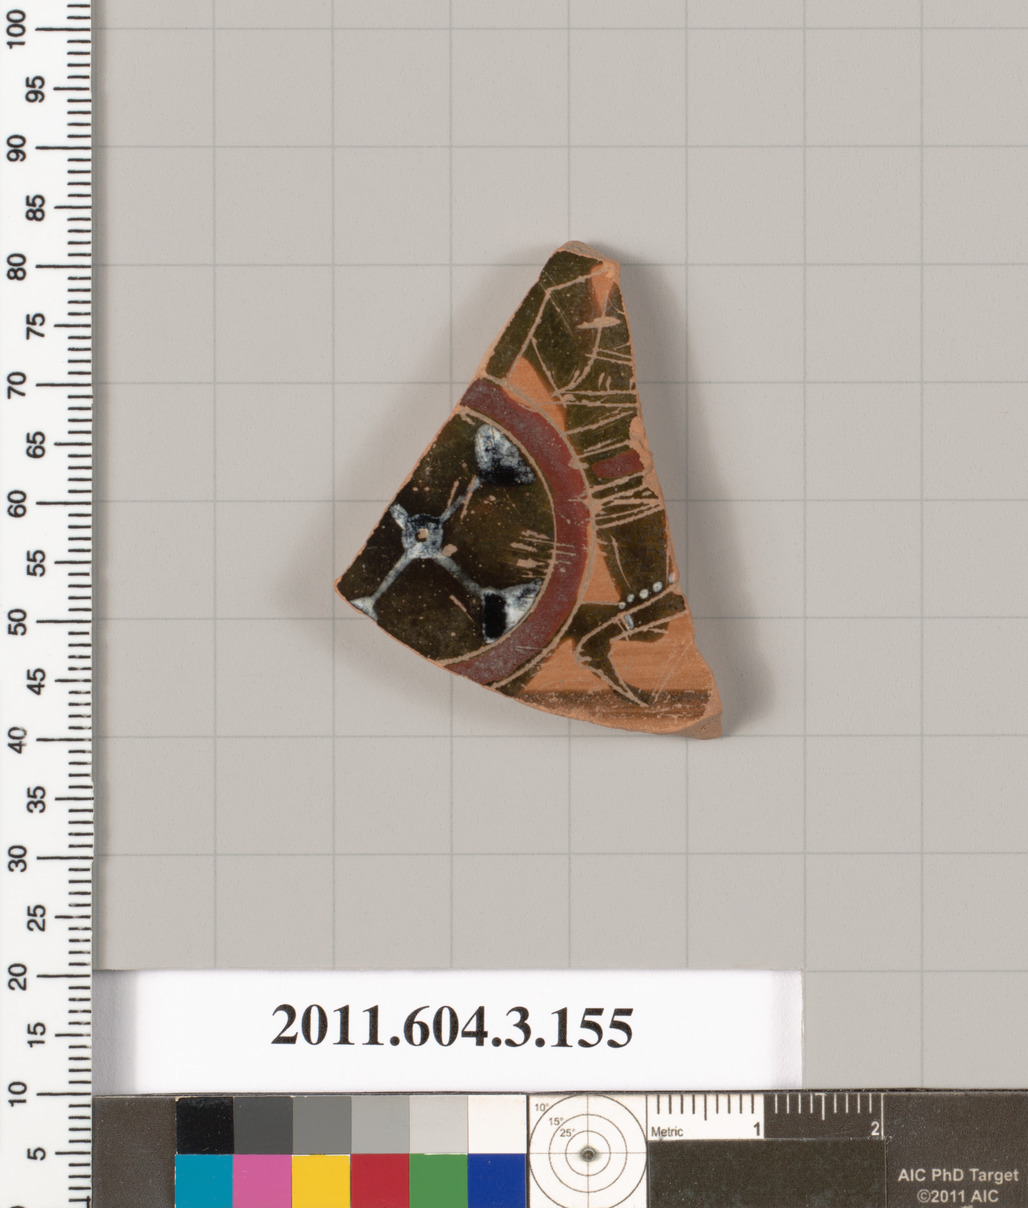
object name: amphora fragment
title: Terracotta fragment of an amphora (jar)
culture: greek, attic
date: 550-540 BCE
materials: terracotta